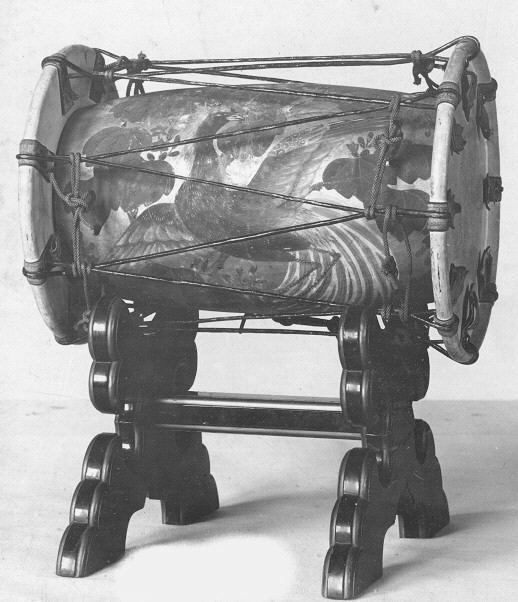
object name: kakko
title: Kakko (羯鼓 or 鞨鼓)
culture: japanese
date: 1801-1900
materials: wood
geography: japan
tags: birds